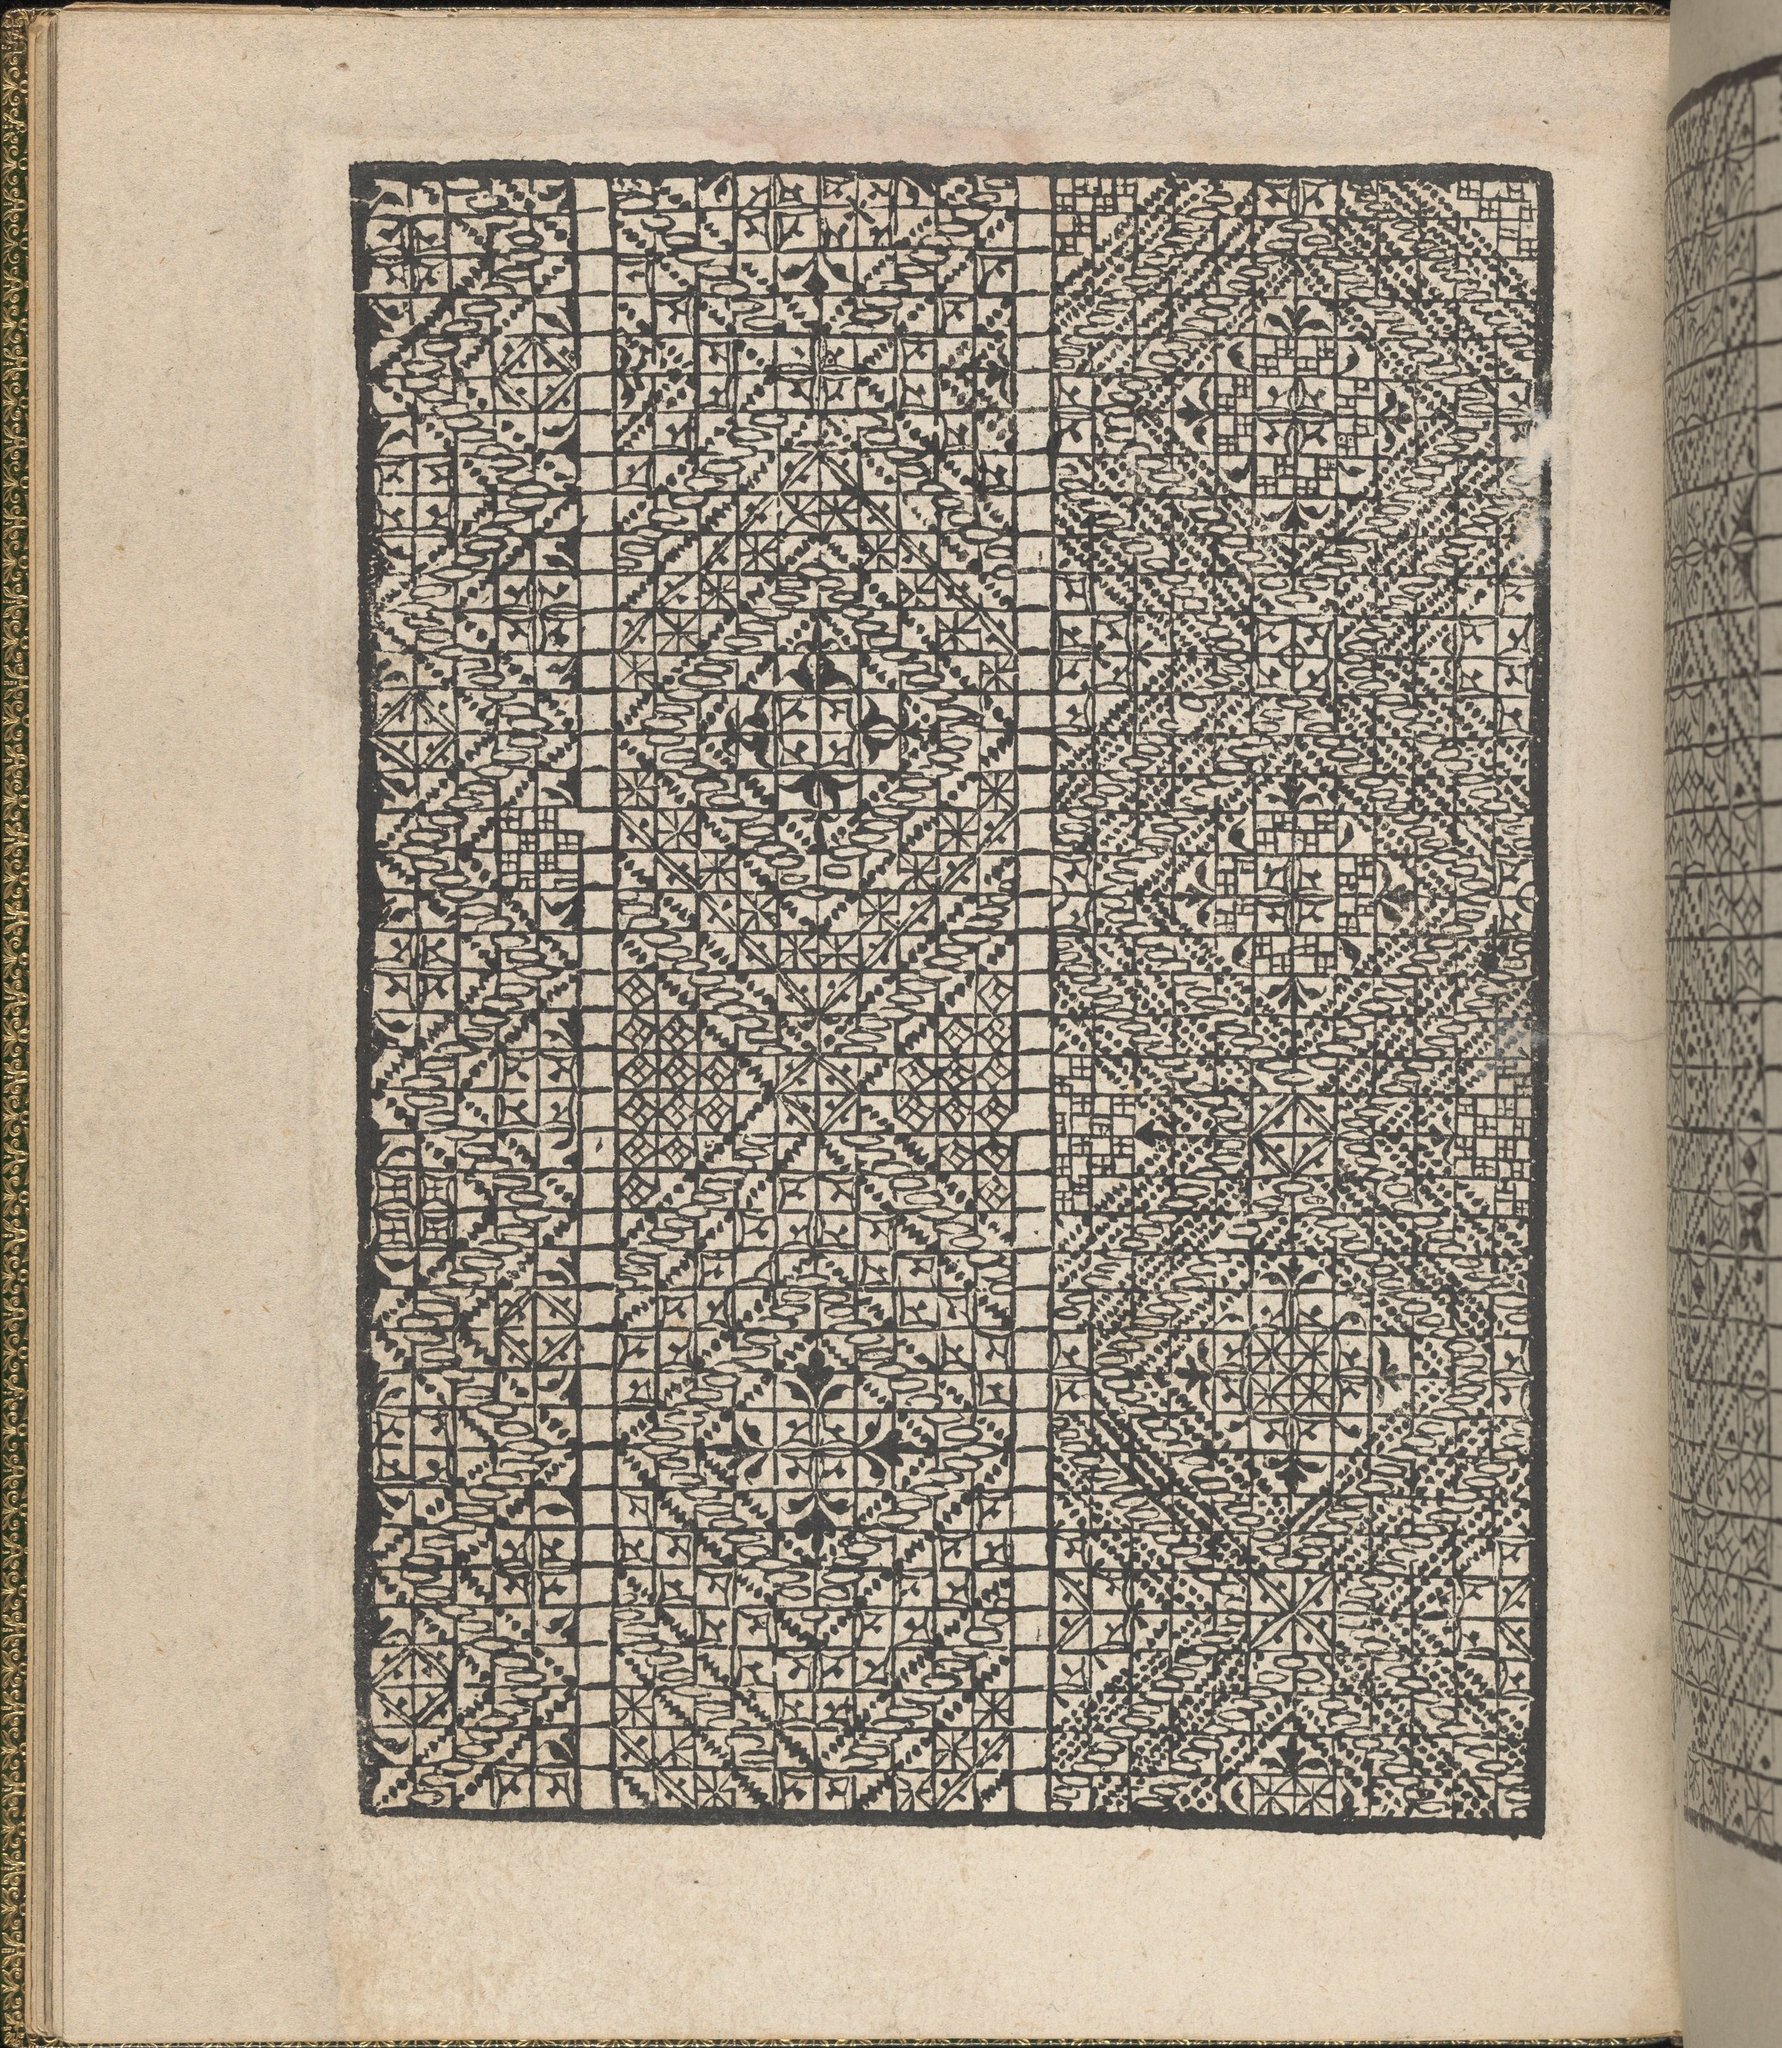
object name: book print ornament architecture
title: Giardineto novo di punti tagliati et gropposi per exercitio & ornamento delle donne (Venice 1554), page 21 (verso)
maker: matteo pagano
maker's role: publisher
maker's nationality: italian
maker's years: 1515-1588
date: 1554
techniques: woodcut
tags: ornament